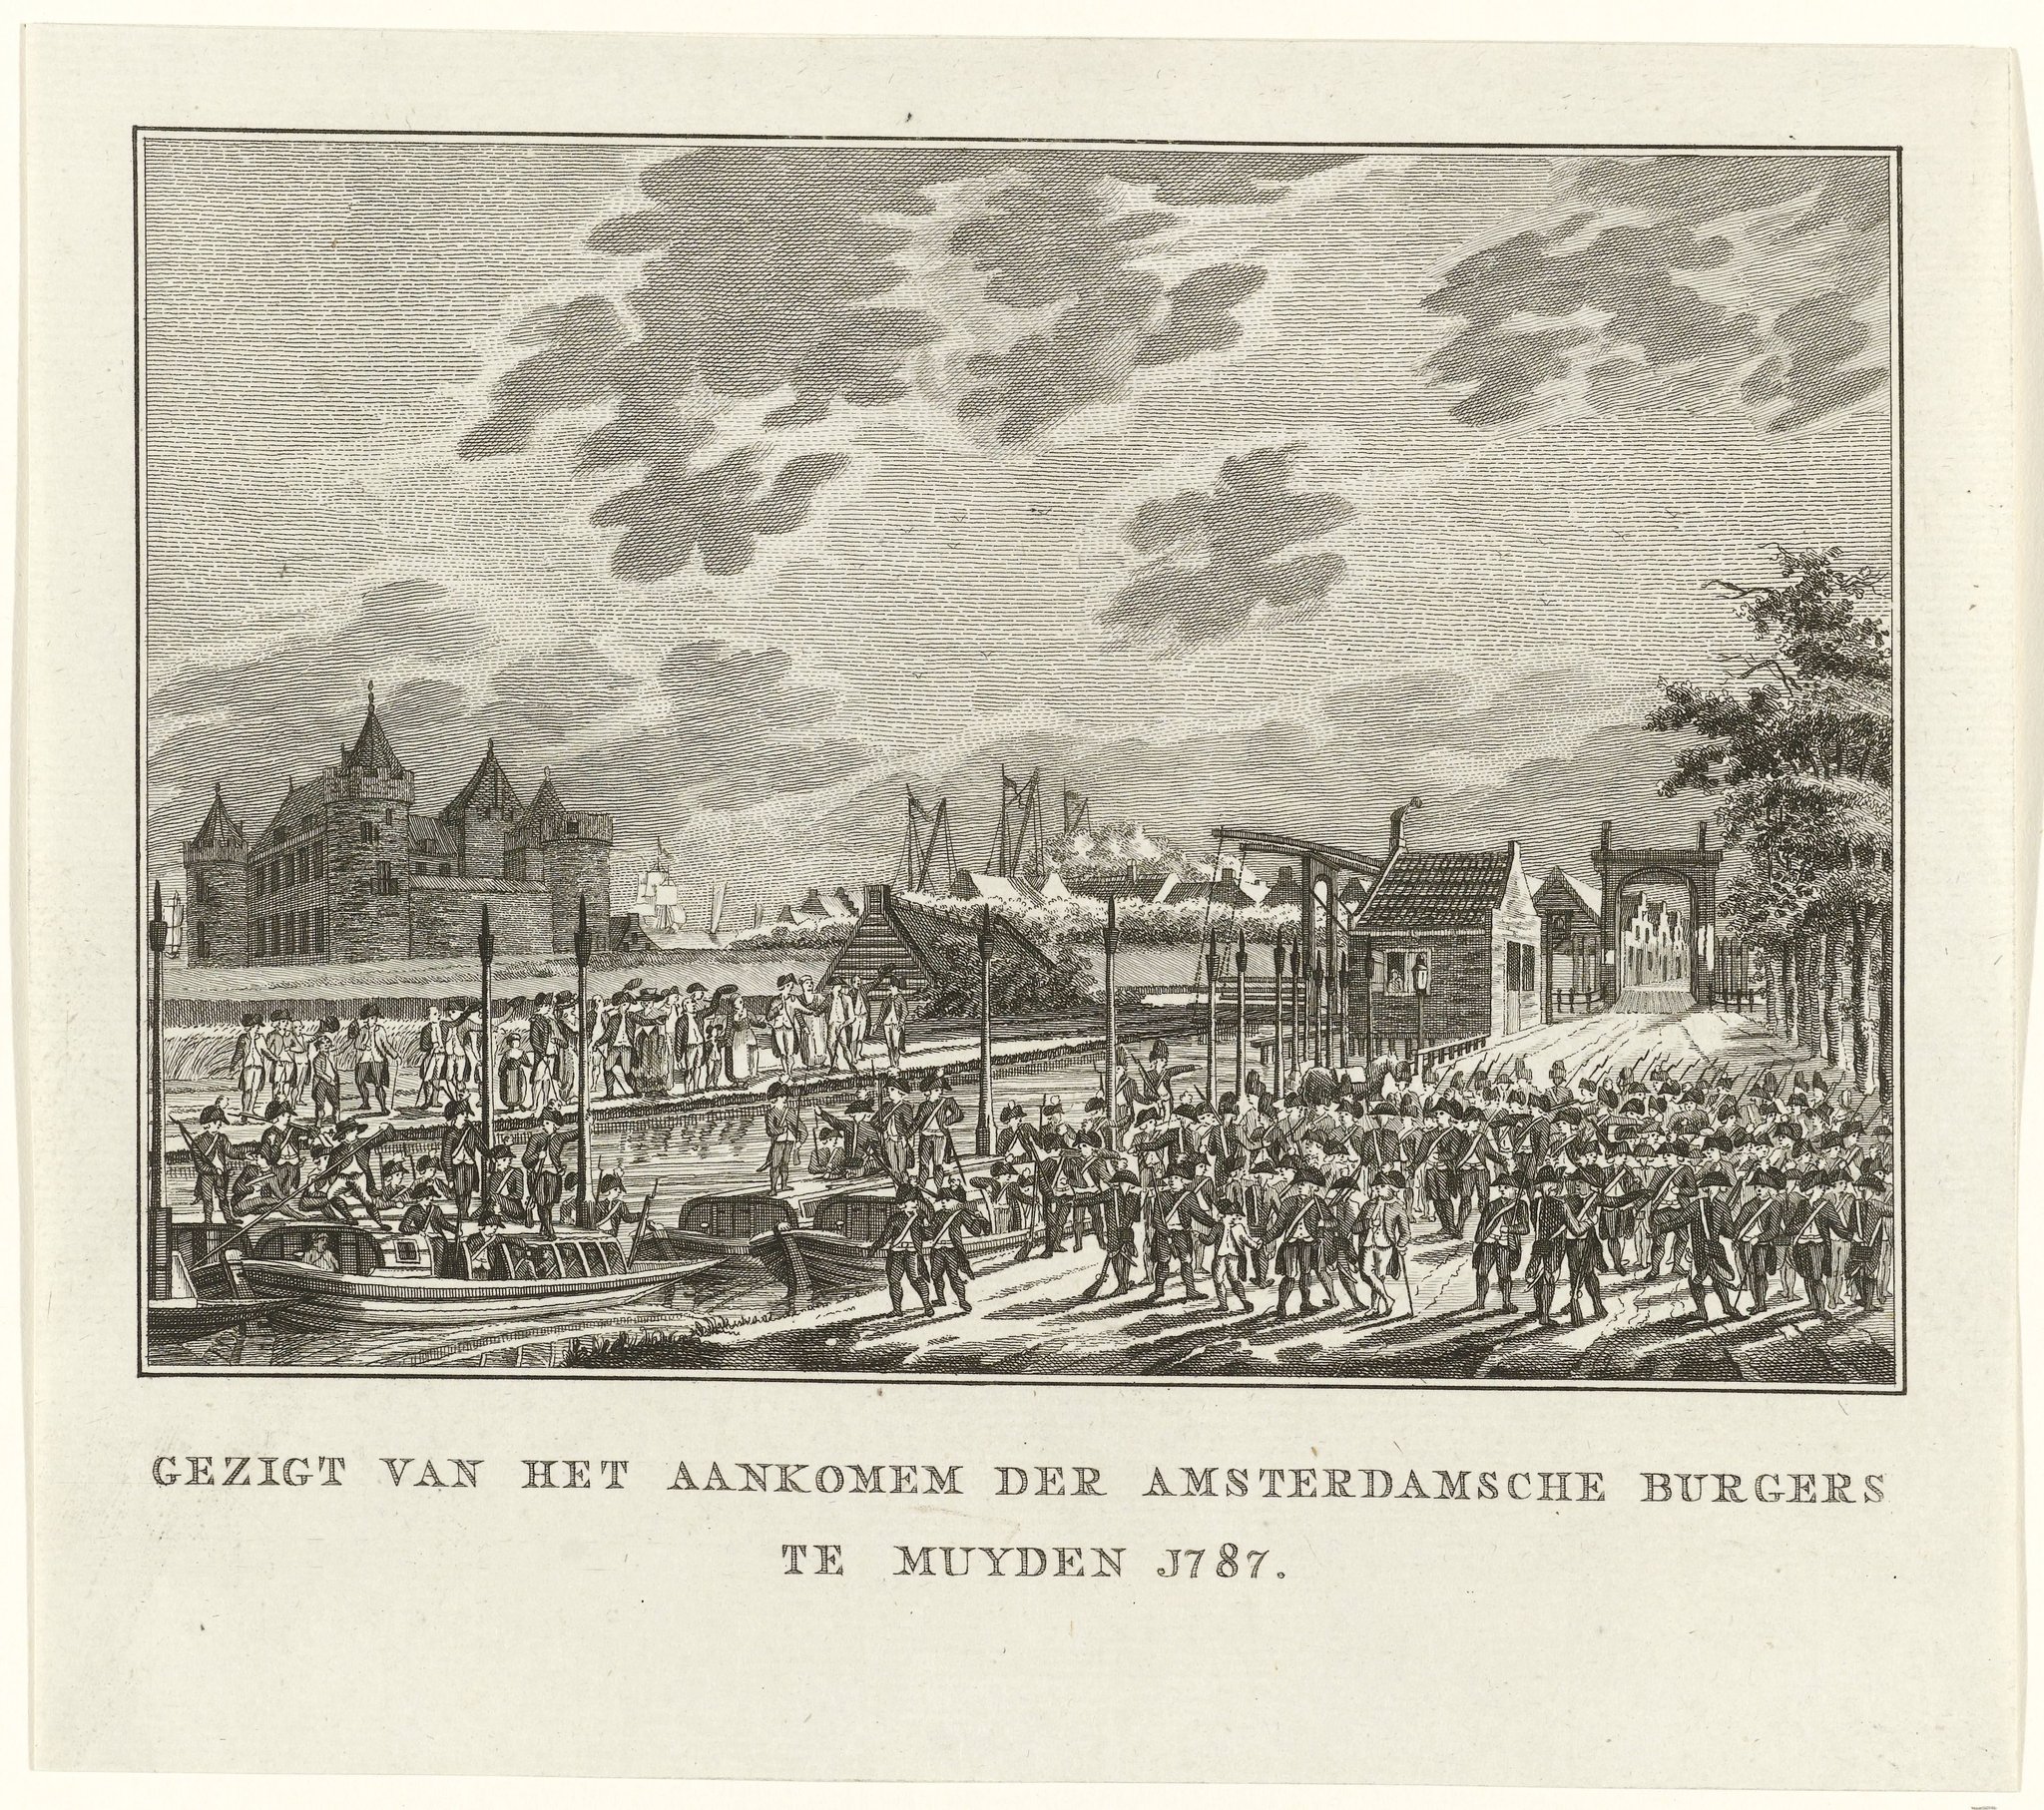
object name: print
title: Aankomst van de gewapende Amsterdamse burgers in Muiden, 1787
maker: Anonymous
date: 1787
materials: paper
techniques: engraving, etching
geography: northern netherlands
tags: patriots (1780-1795)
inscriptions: collector's mark: Lugt 2228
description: Aankomst van de boten met gewapende Amsterdamse burgers te Muiden, 7 juni 1787. Op de achtergrond het Muiderslot. De prent heeft een pendant.